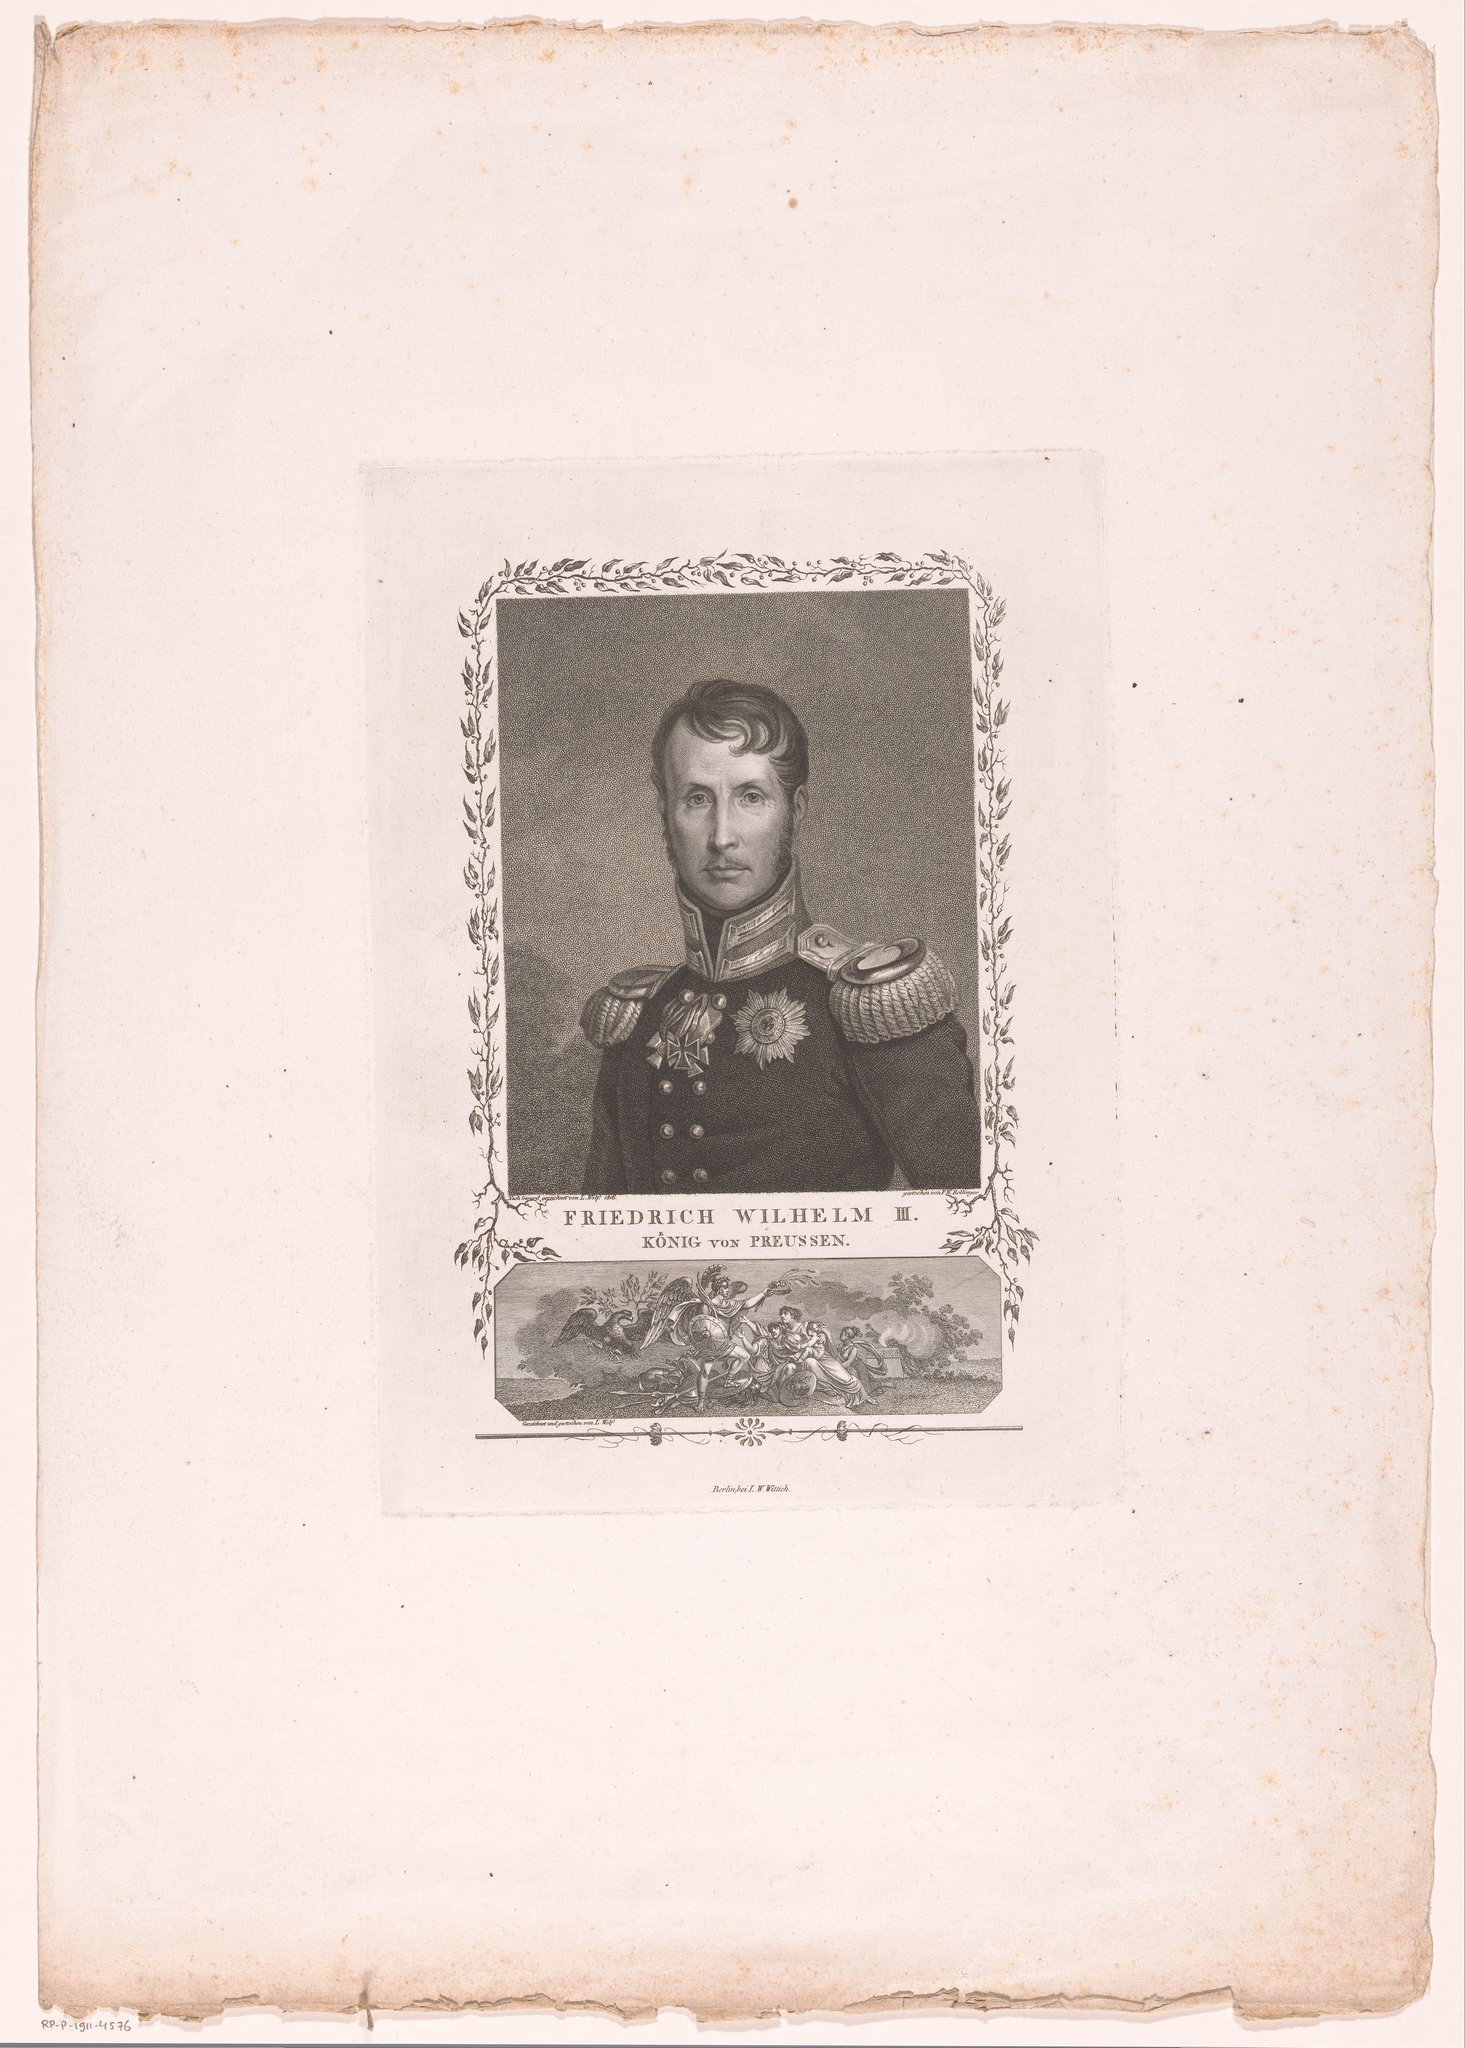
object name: print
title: Portret van Friedrich Wilhelm III van Pruisen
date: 1816-1825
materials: paper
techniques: etching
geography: berlin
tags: berlin, frederik willem iii koning van pruisen, knighthood order (with name) - insignia of a knighthood order, e.g.: badge, chain (with name of order), knighthood order, historical persons, (military) uniforms, specific aspects, allegorical aspects of mars; mars as patron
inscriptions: collector's mark: Lugt 2228